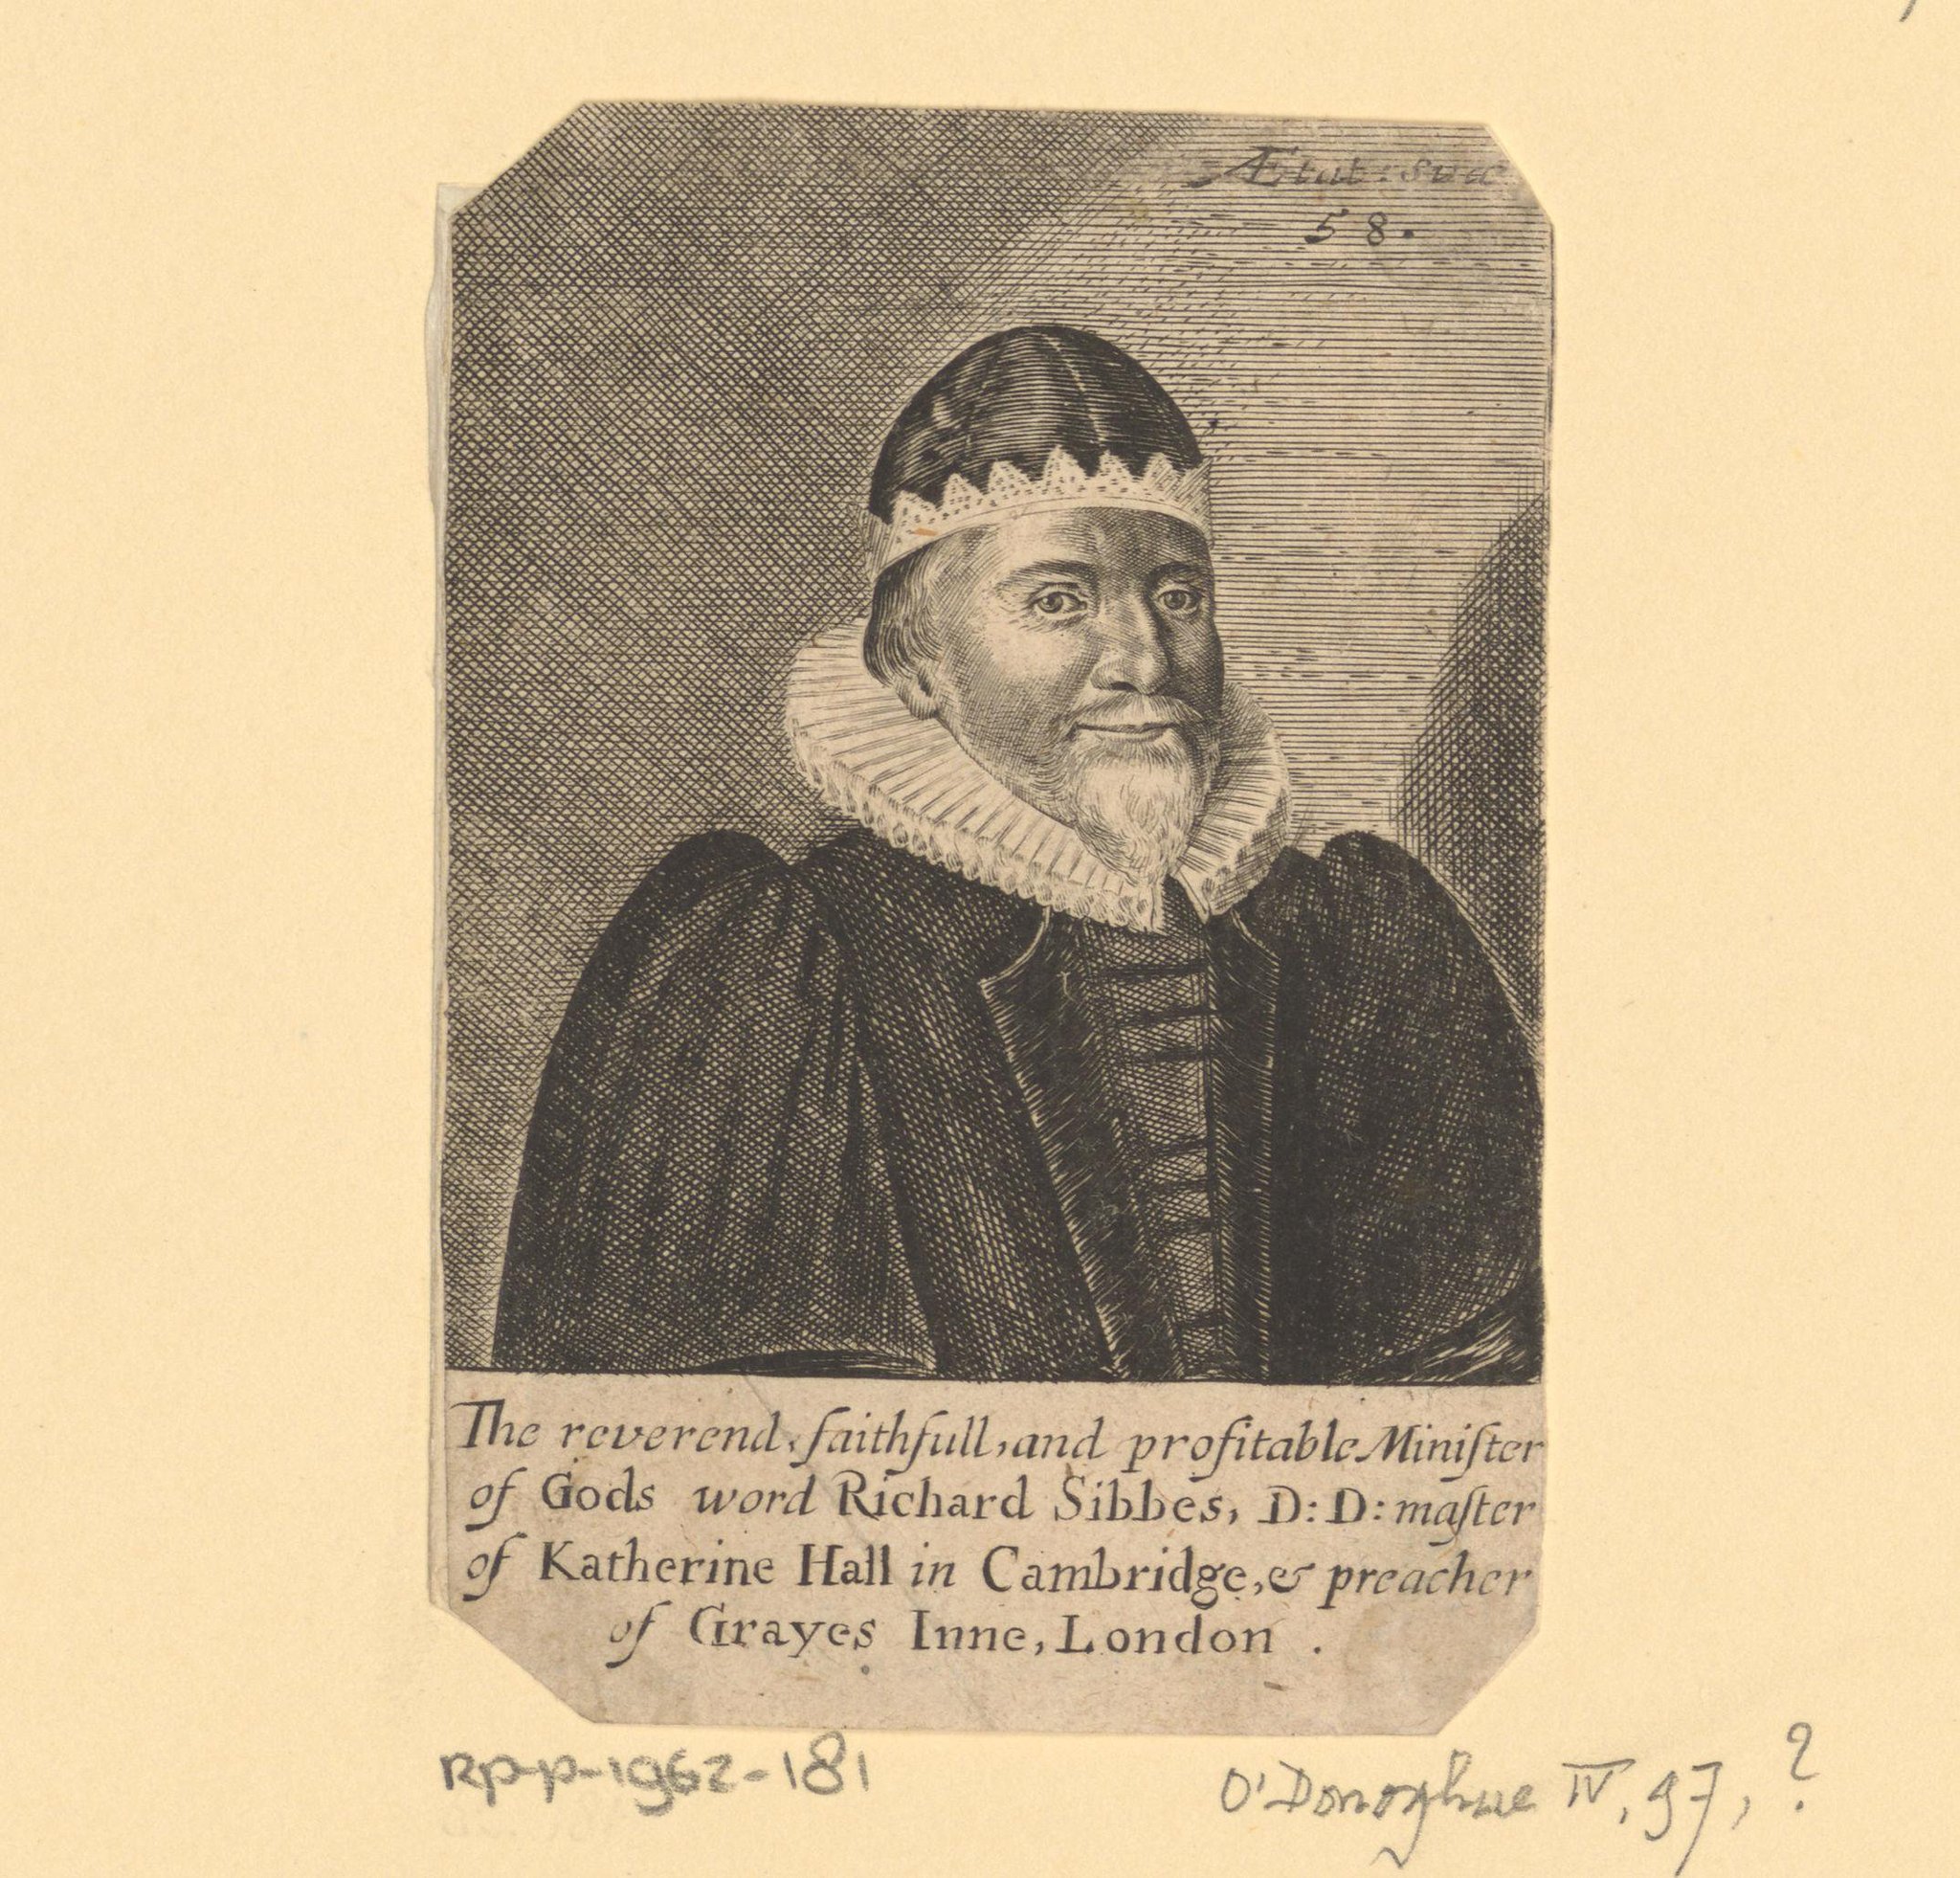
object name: print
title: Portret van Richard Sibbes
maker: Anonymous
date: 1626-1750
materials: paper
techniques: engraving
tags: theologian, historical persons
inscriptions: collector's mark: Lugt 151